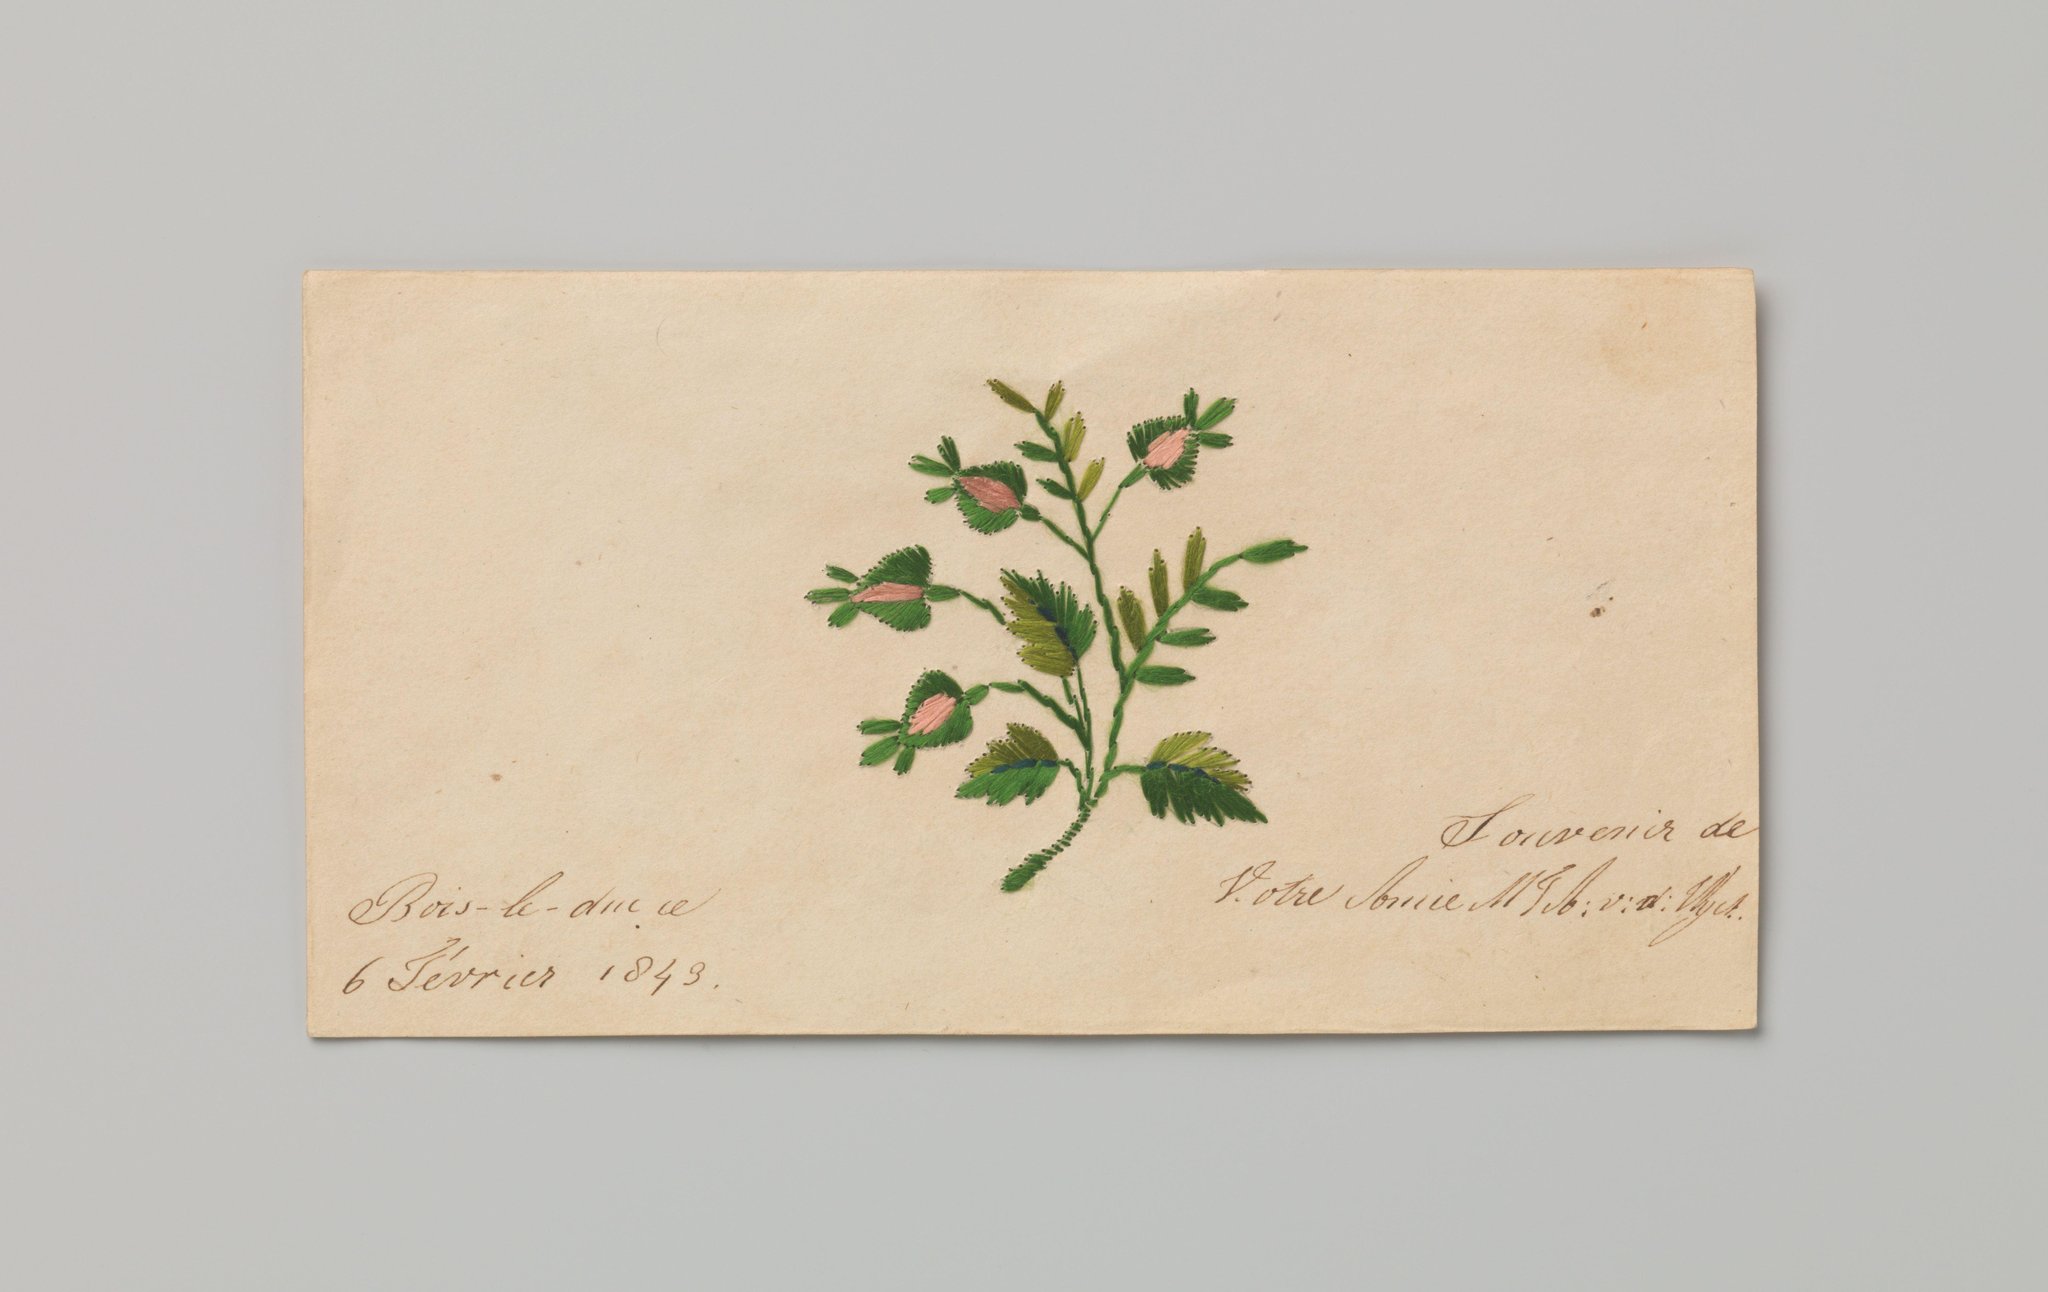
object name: album leaf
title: Een bladzijde uit een album met een borduurwerk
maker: Anonymous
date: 1843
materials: paper, silk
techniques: embroidered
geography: den bosch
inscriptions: date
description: Een bladzijde uit een album. Op het papieren stramien is een tak geborduurd in groene en roze zijde met de tekst: Bois-le-ducie 6 Fevrier 1843 Souvenir de votre Amie MJA vd Vught.